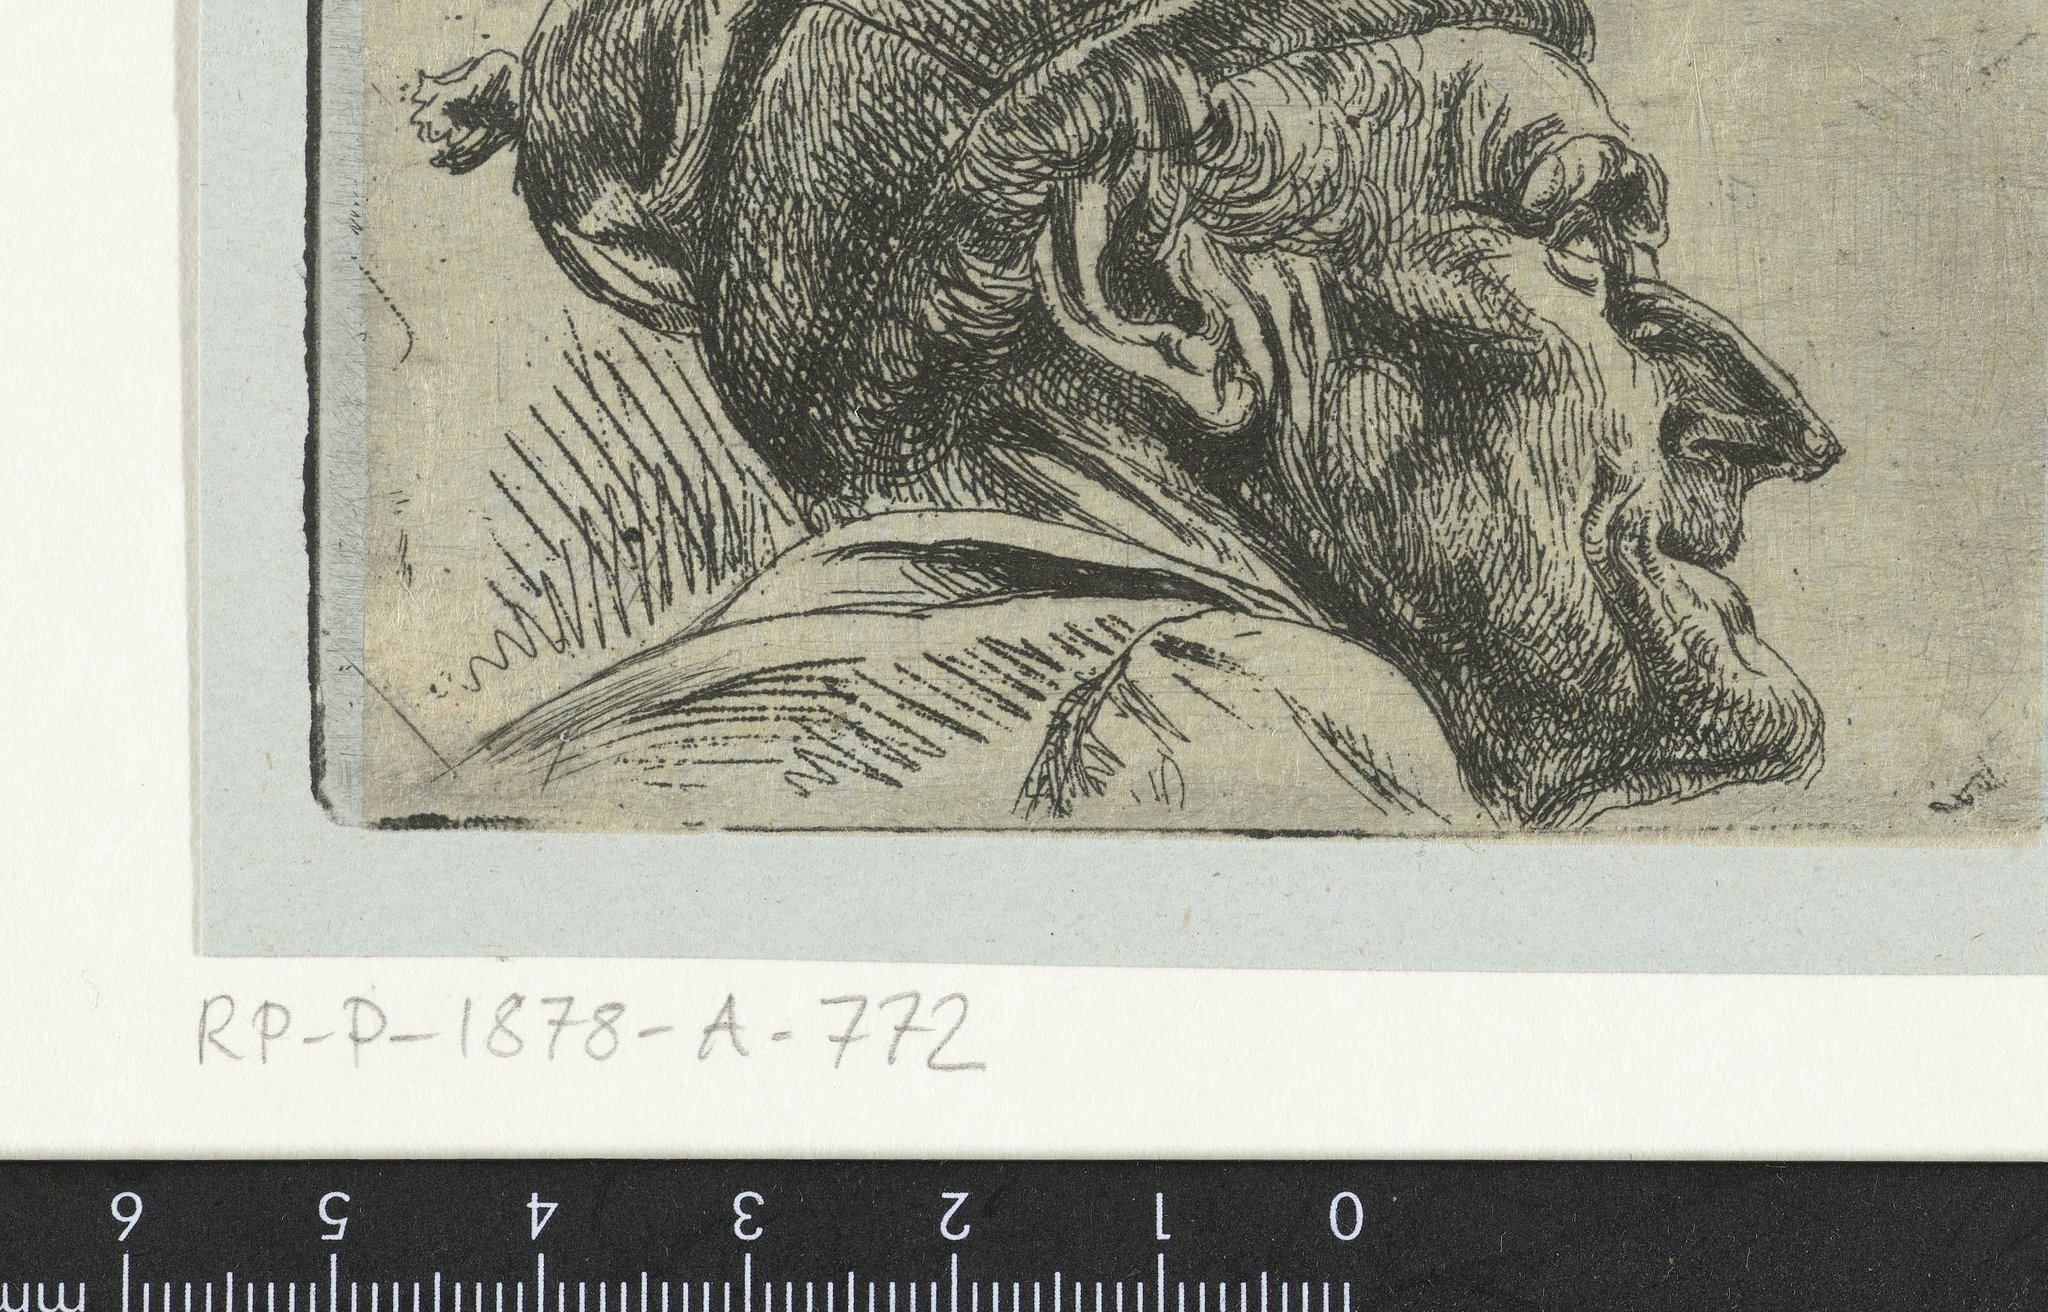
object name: print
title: Hoofd van een boer met muts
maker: thomas simon cool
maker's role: draughtsman, print maker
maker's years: 1831-1870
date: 1862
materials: paper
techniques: etching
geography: netherlands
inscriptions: date